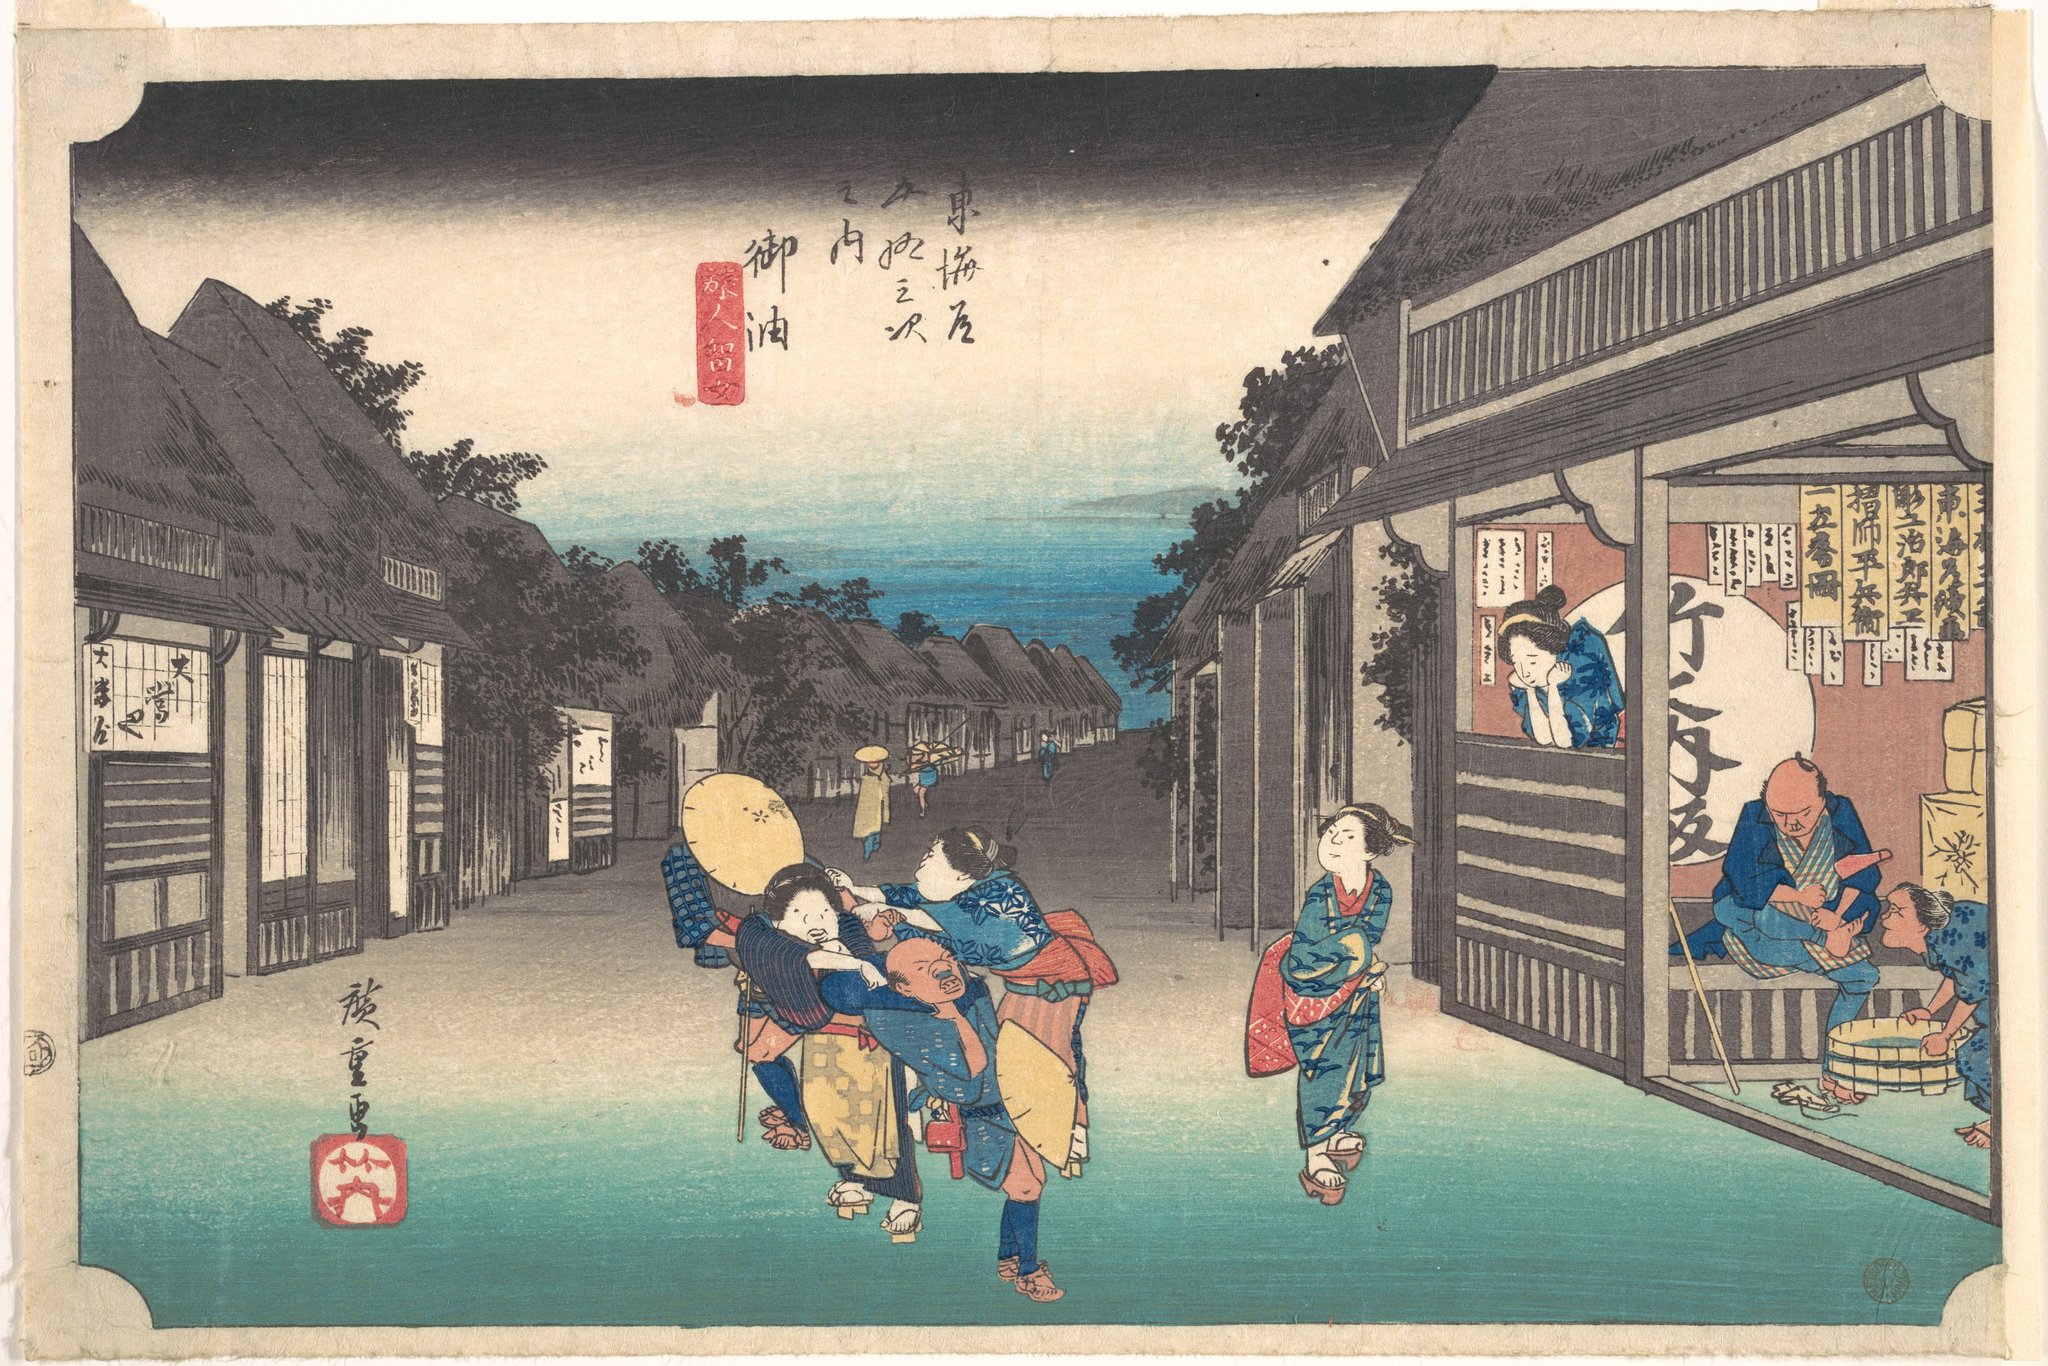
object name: print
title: Goyu, Tabibito Ryujo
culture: japanese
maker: utagawa hiroshige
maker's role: artist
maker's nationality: japanese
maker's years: 1797-1858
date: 1833-1834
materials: ink, paper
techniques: woodblock print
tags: inns,men,women,daily life